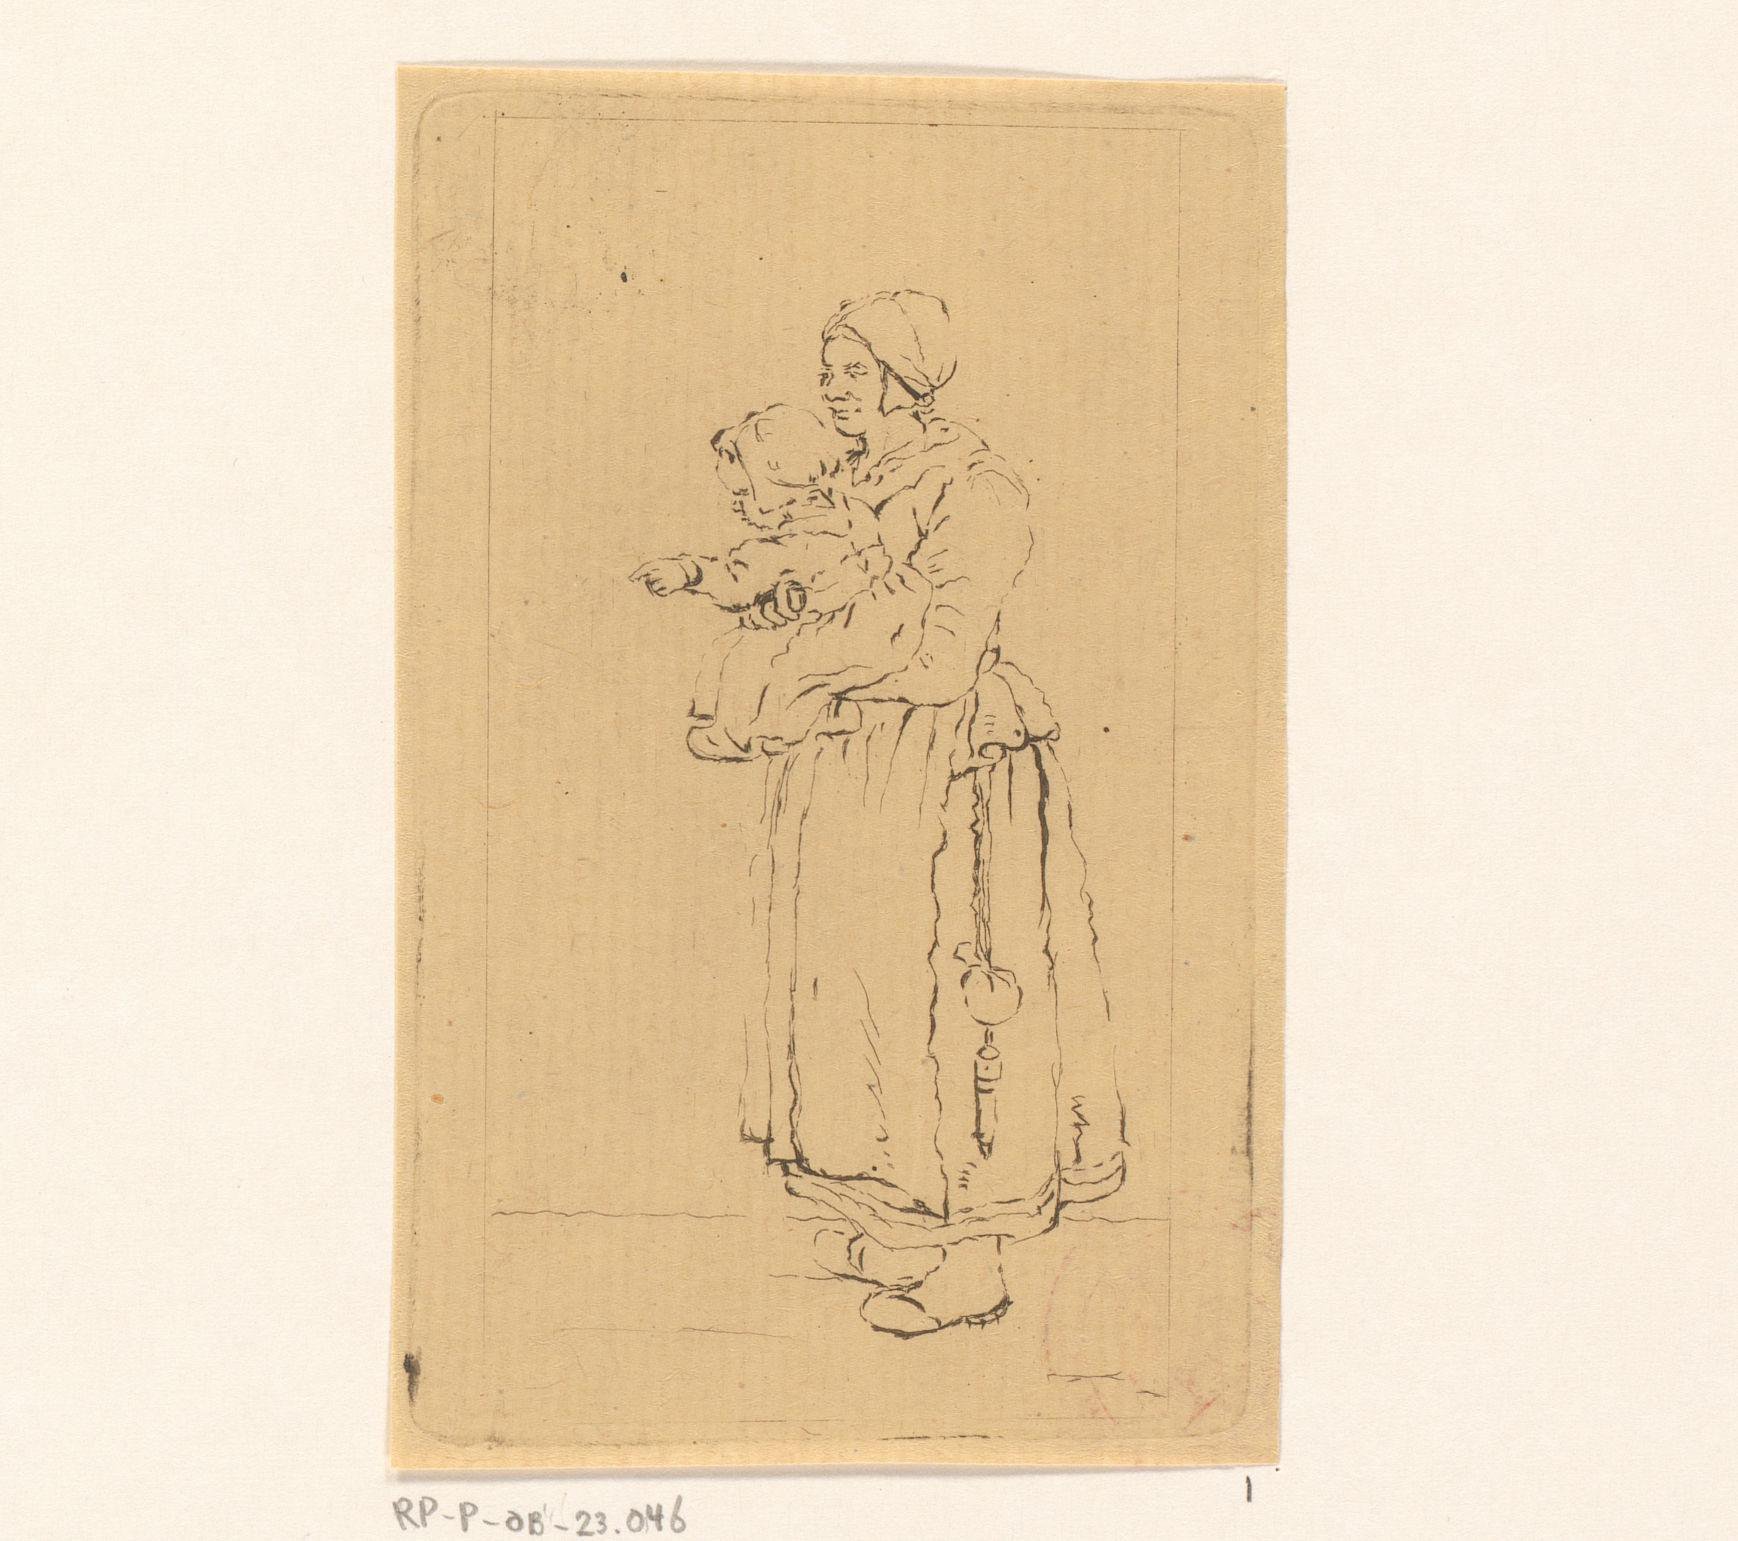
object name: print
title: Staande moeder met kind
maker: pieter de mare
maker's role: print maker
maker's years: 1758-1796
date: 1779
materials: paper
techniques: etching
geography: leiden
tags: mother and baby or young child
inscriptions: collector's mark: Lugt 240